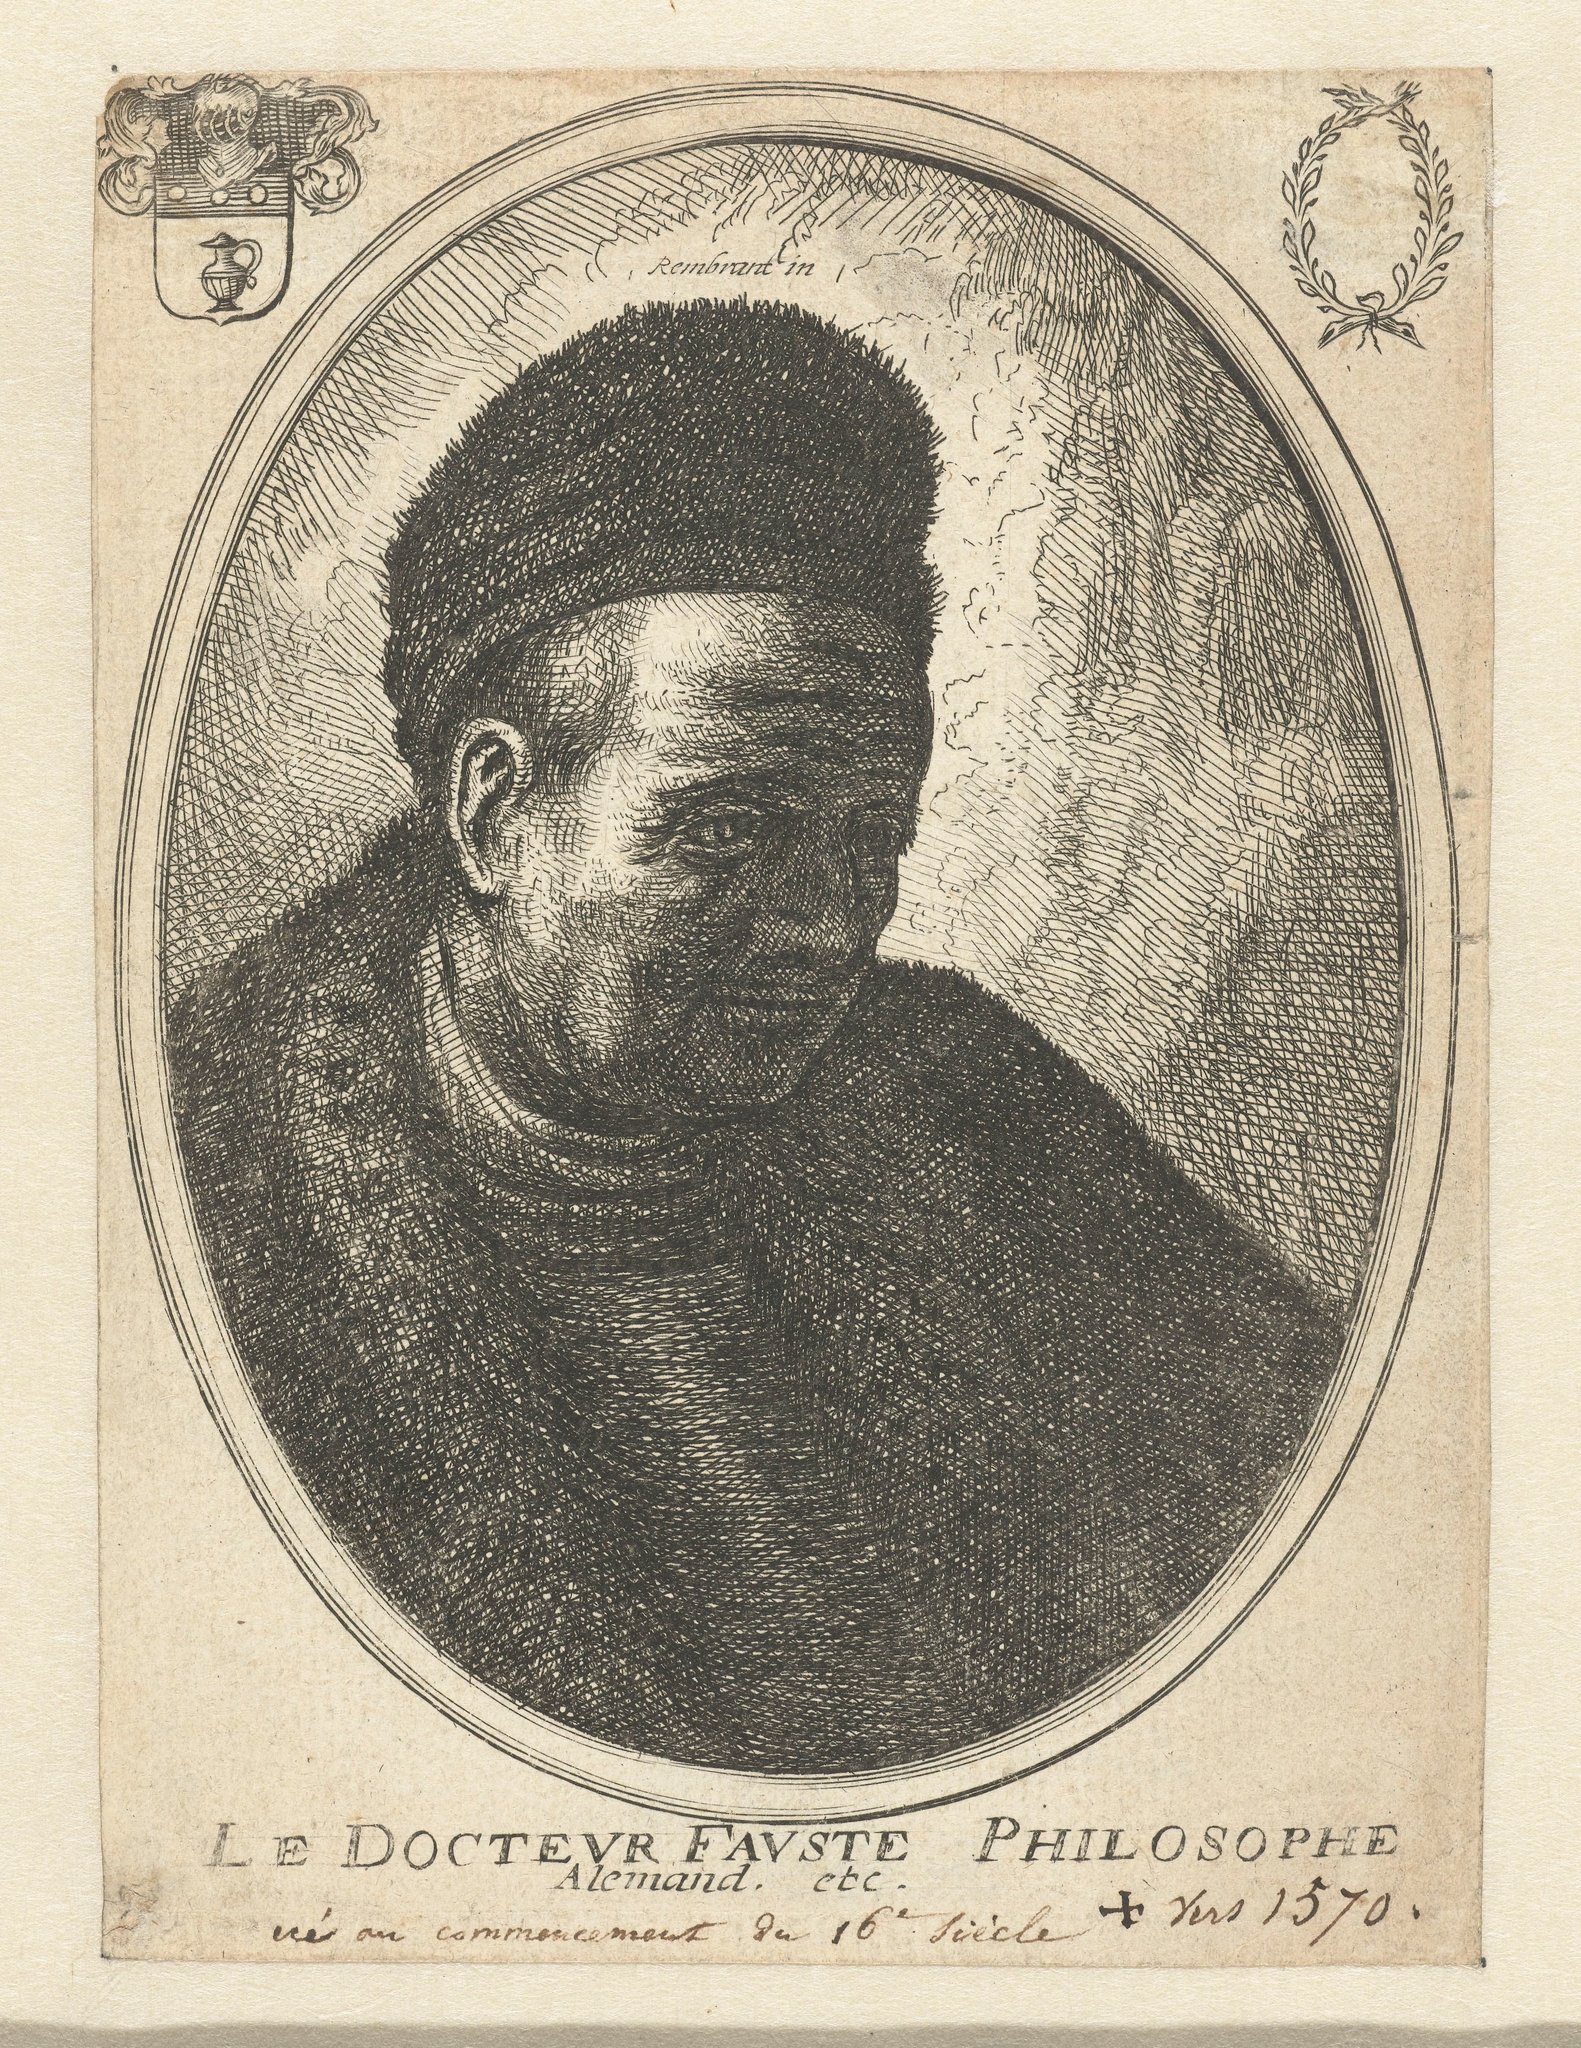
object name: print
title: Beardless man in a fur cloak and cap: bust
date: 1631-1668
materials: paper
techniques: etching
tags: head-gear (with name), adult man, armorial bearing, heraldry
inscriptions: collector's mark: Lugt 4071, :, collector's mark: Lugt 2228, collector's mark: Lugt 2760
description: Spiegelbeeldige kopie naar de gelijknamige prent van Rembrandt.